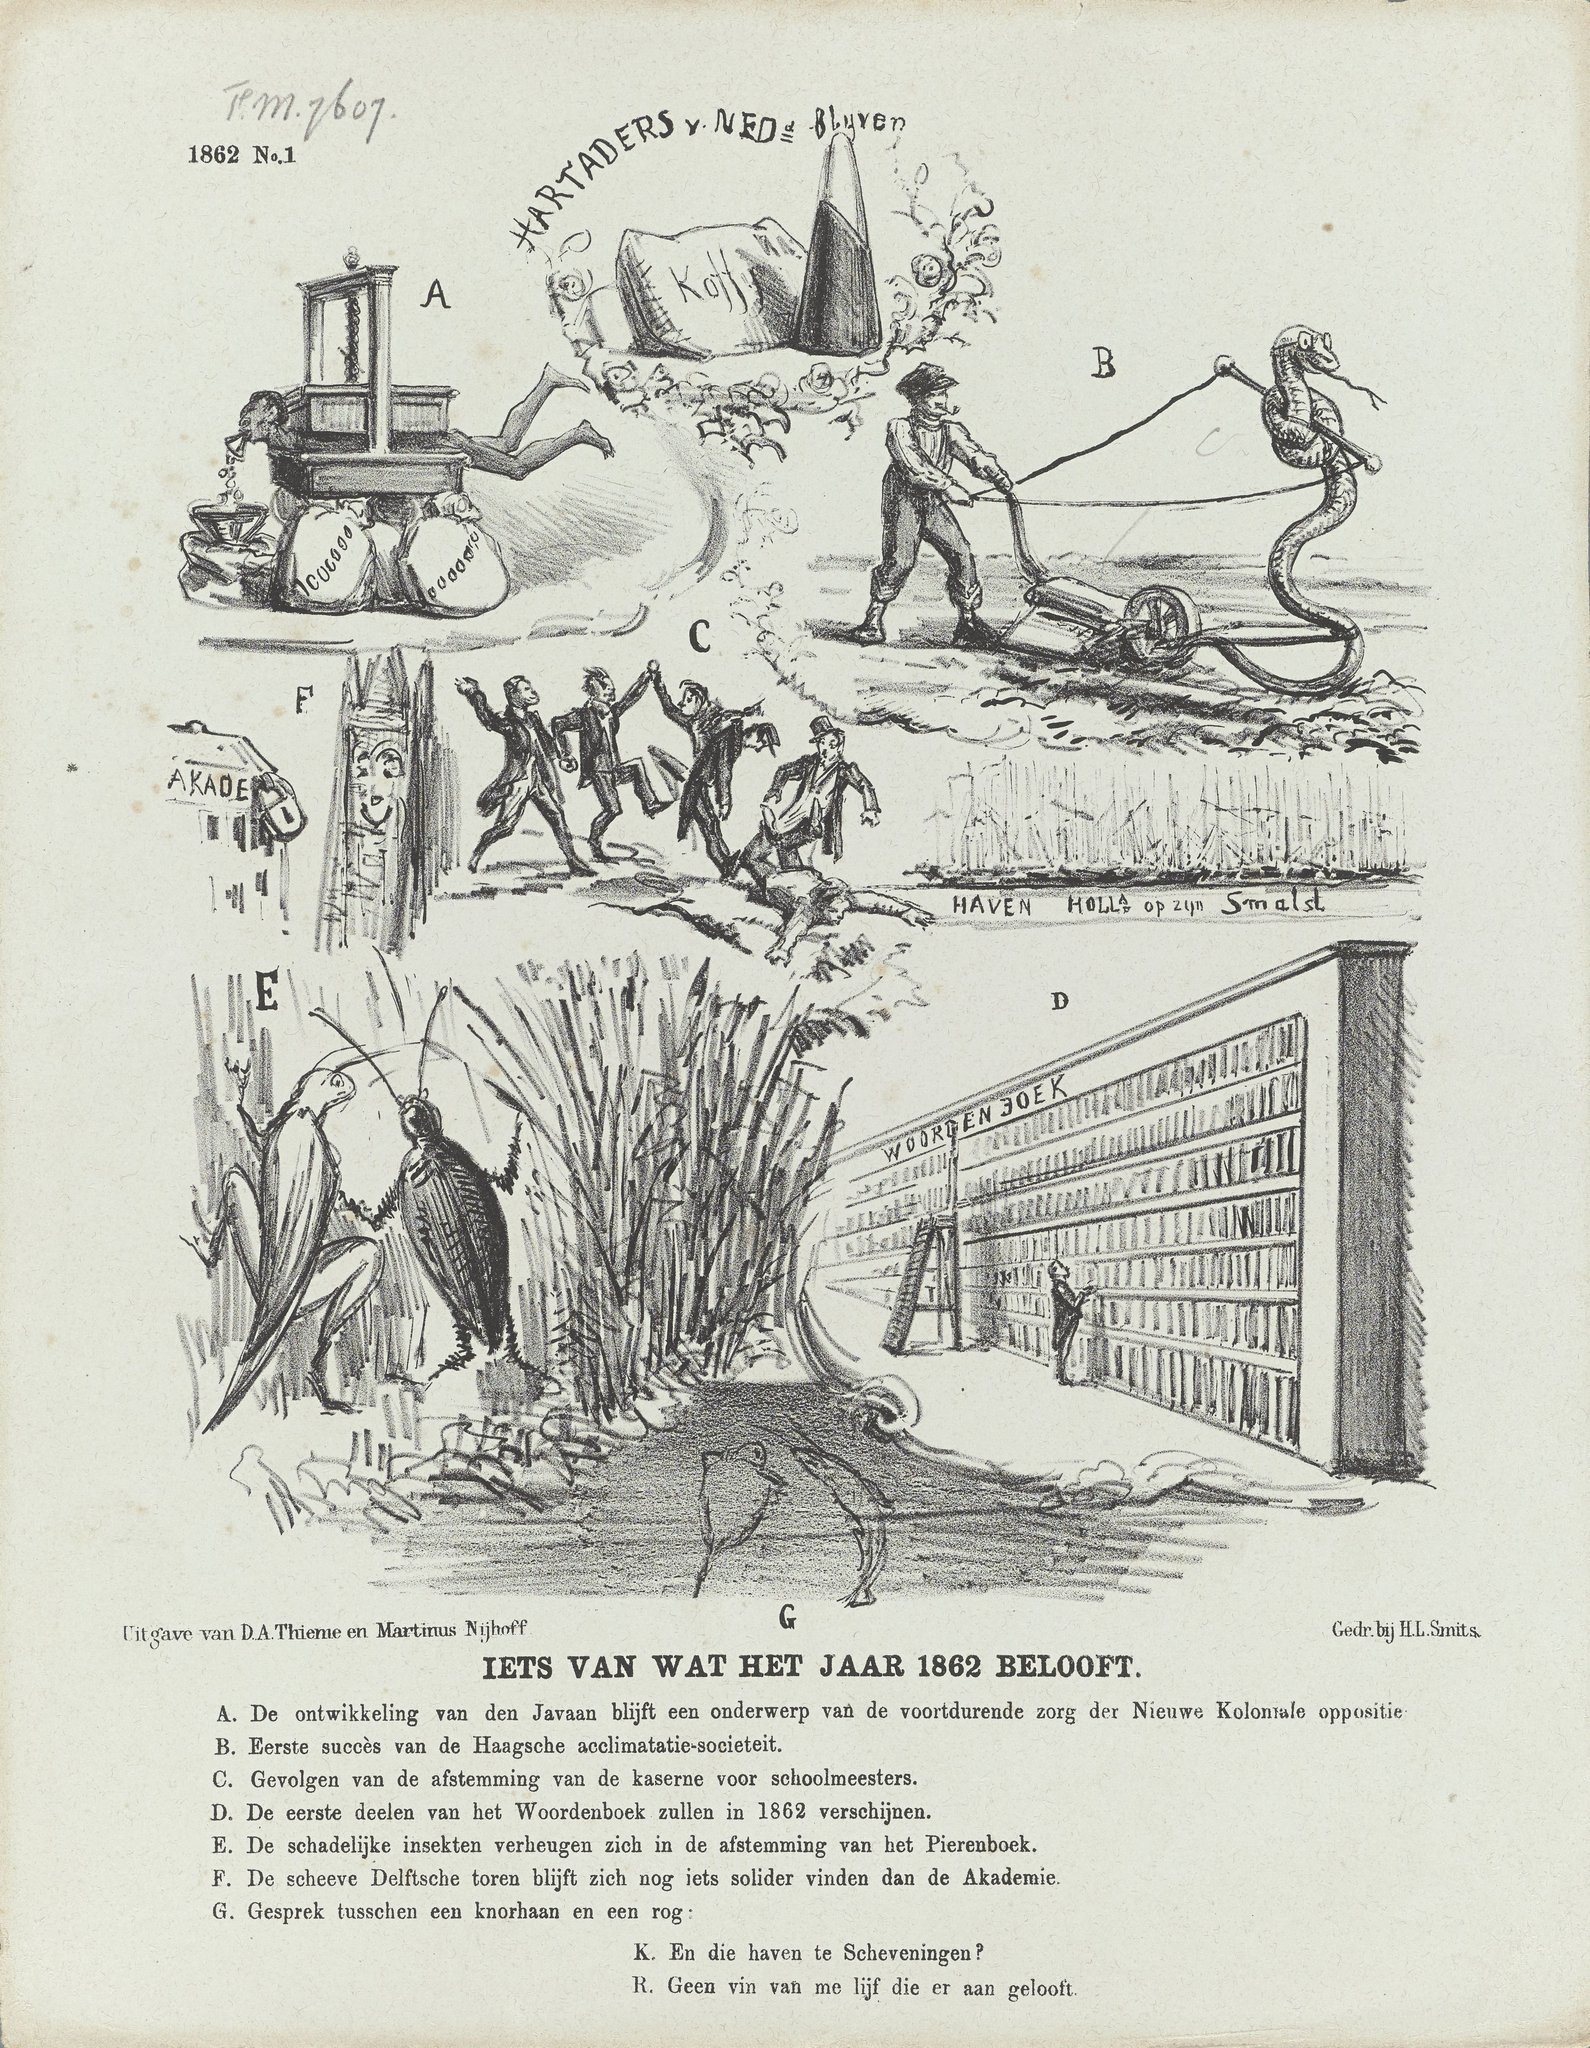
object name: cartoon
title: Iets van wat het jaar 1862 belooft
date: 1862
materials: paper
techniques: lithograph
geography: netherlands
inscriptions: collector's mark: Lugt 2228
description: Spotprent op de plannen voor het komende jaar 1862. Overzicht van plannen A-G, waaronder: de scheve kerktoren te Delft, de Woordenboek, en de ontwikkeling v an de Javaan. Plaat verschenen bij het weekblad De Nederlandsche Spectator, nr. 1, 4 januari 1862.